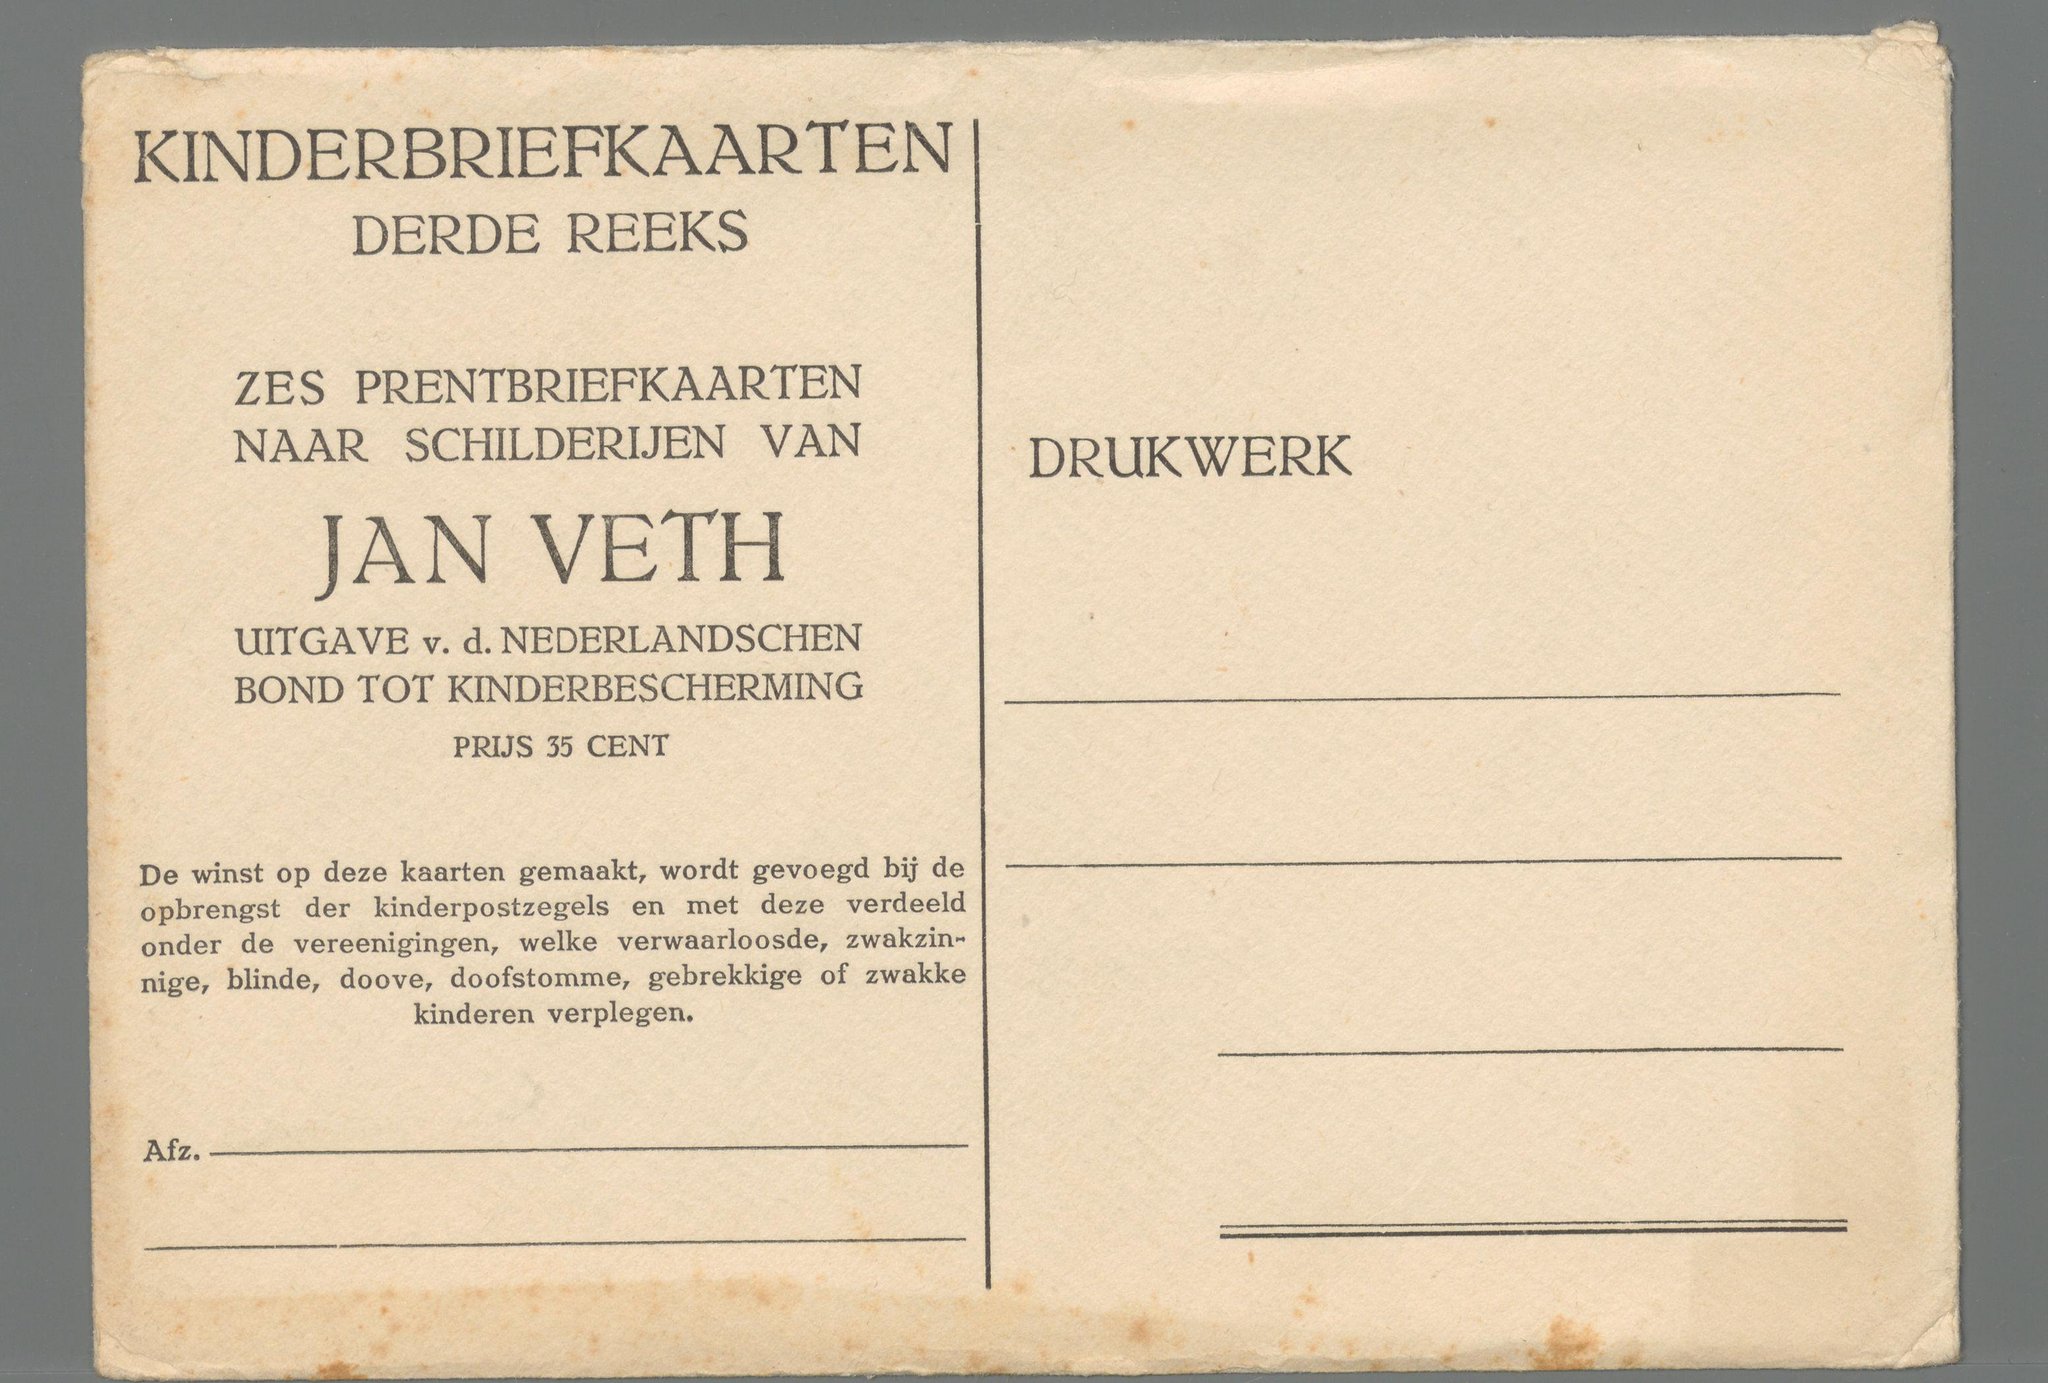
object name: wrapper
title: Kinderbriefkaarten derde reeks. Zes prentbriefkaarten naar schilderingen van Jan Veth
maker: Anonymous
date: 1928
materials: paper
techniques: printing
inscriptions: collector's mark: ‘AFE v S’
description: Het omslag is bedoeld voor zes prentbriefkaarten uit serie drie. In dit exemplaar zijn vijf prentbriefkaarten uit serie drie en een prentbriefkaart uit serie vier aangetroffen.